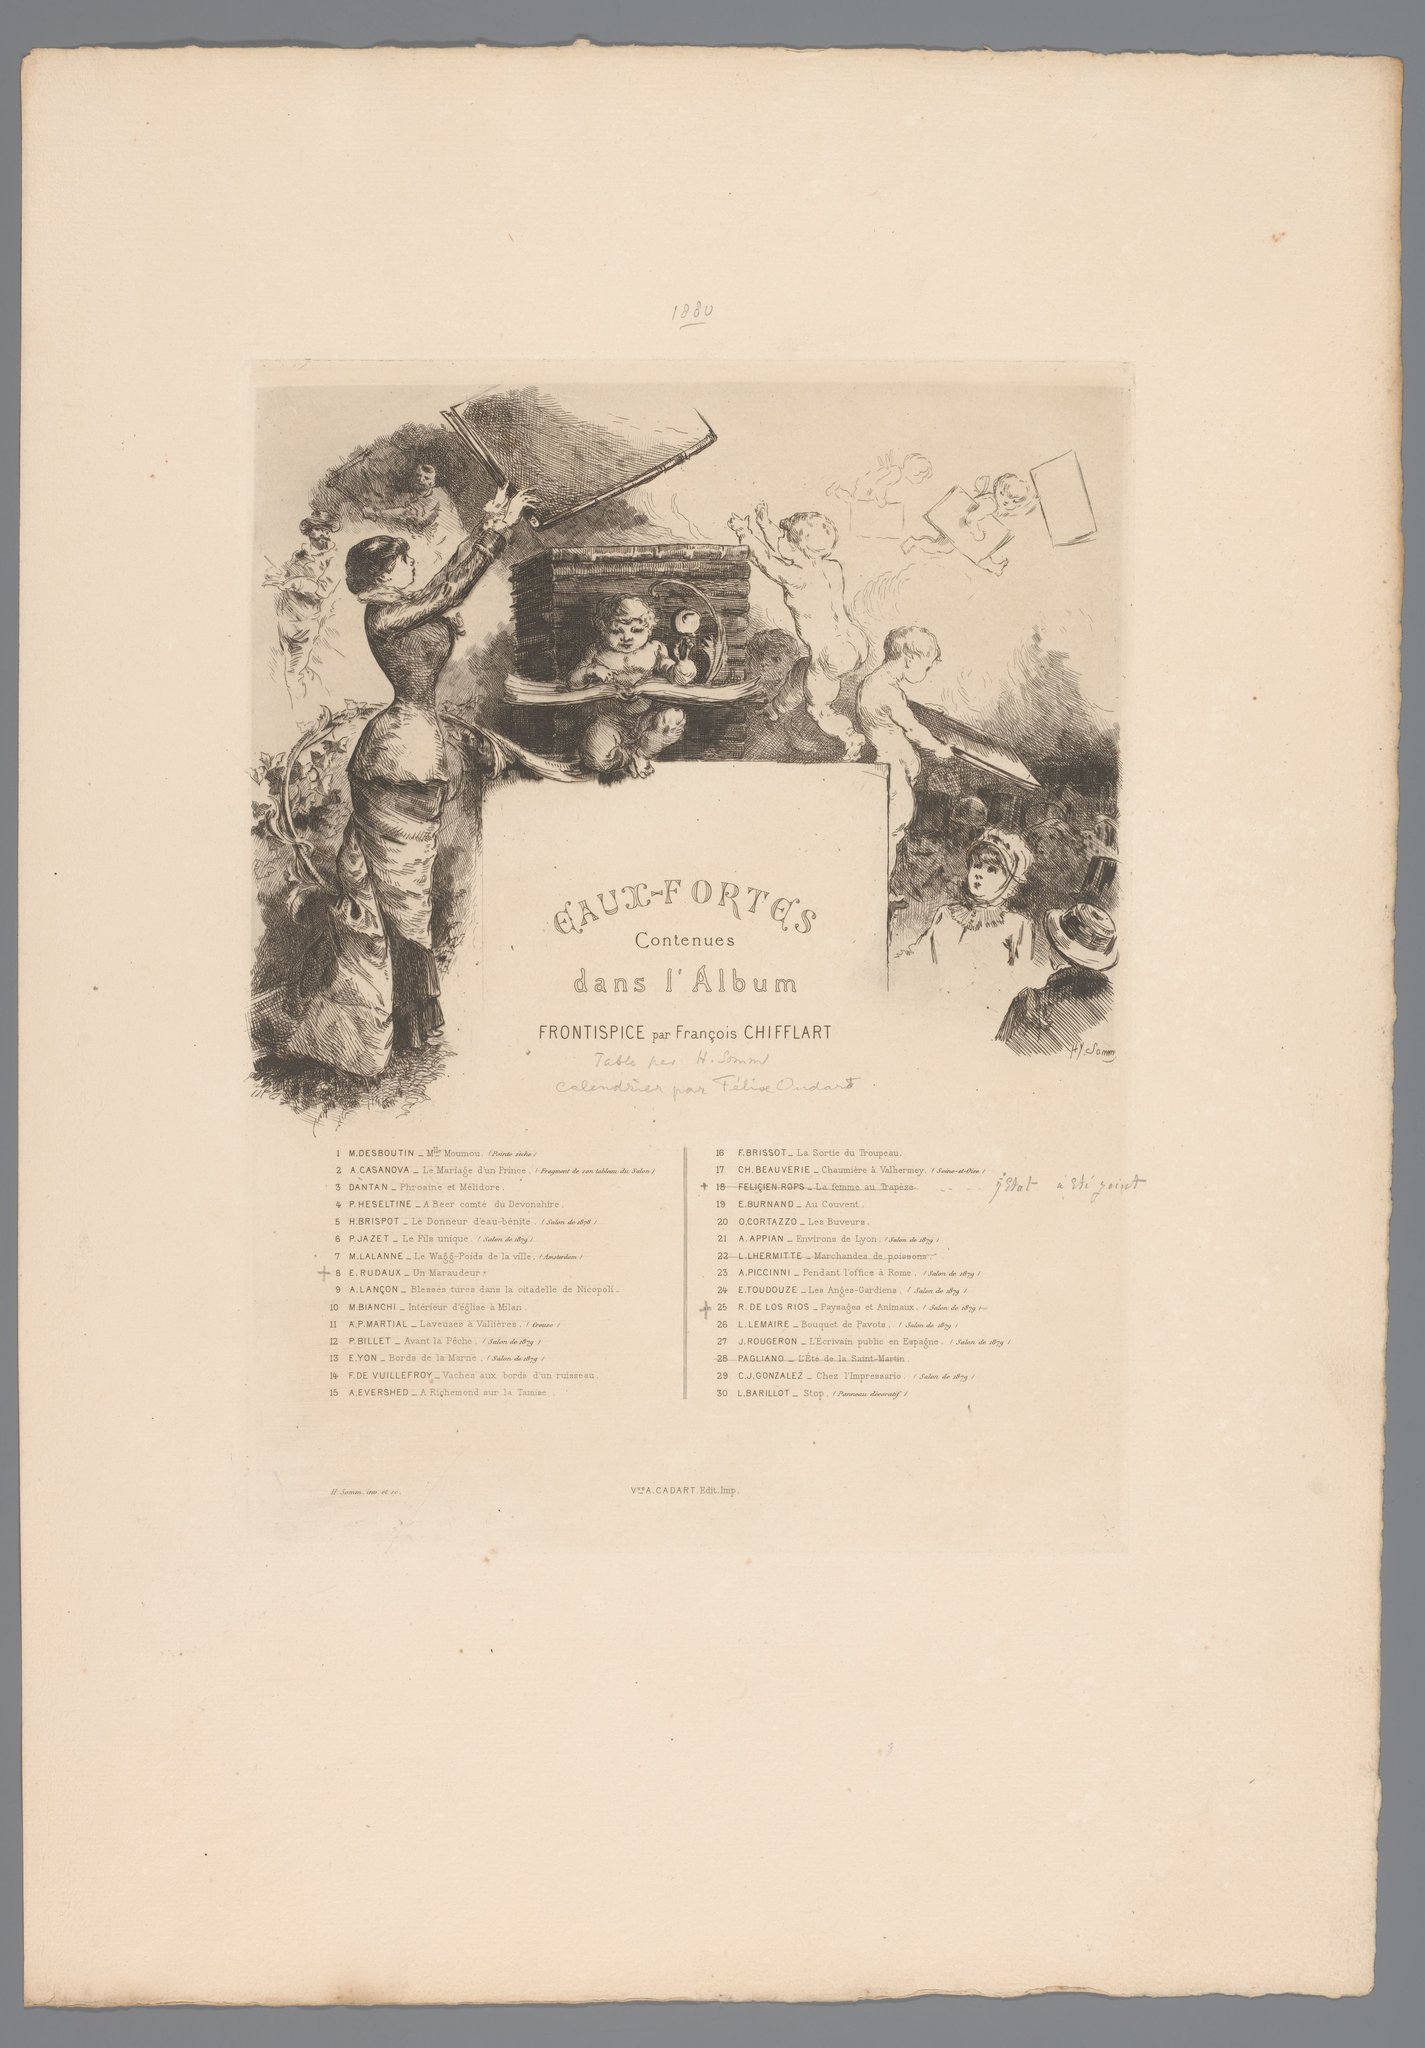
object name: print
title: Vrouw en putti bij stapel prentalbums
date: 1880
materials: paper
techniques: drypoint, etching, intaglio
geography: paris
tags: adult woman, printing, printing office, cupids: 'amores', 'amoretti', 'putti'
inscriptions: collector's mark: Lugt 2228, collector's mark: ‘AFE v S’, collector's mark: Lugt 2760, watermark